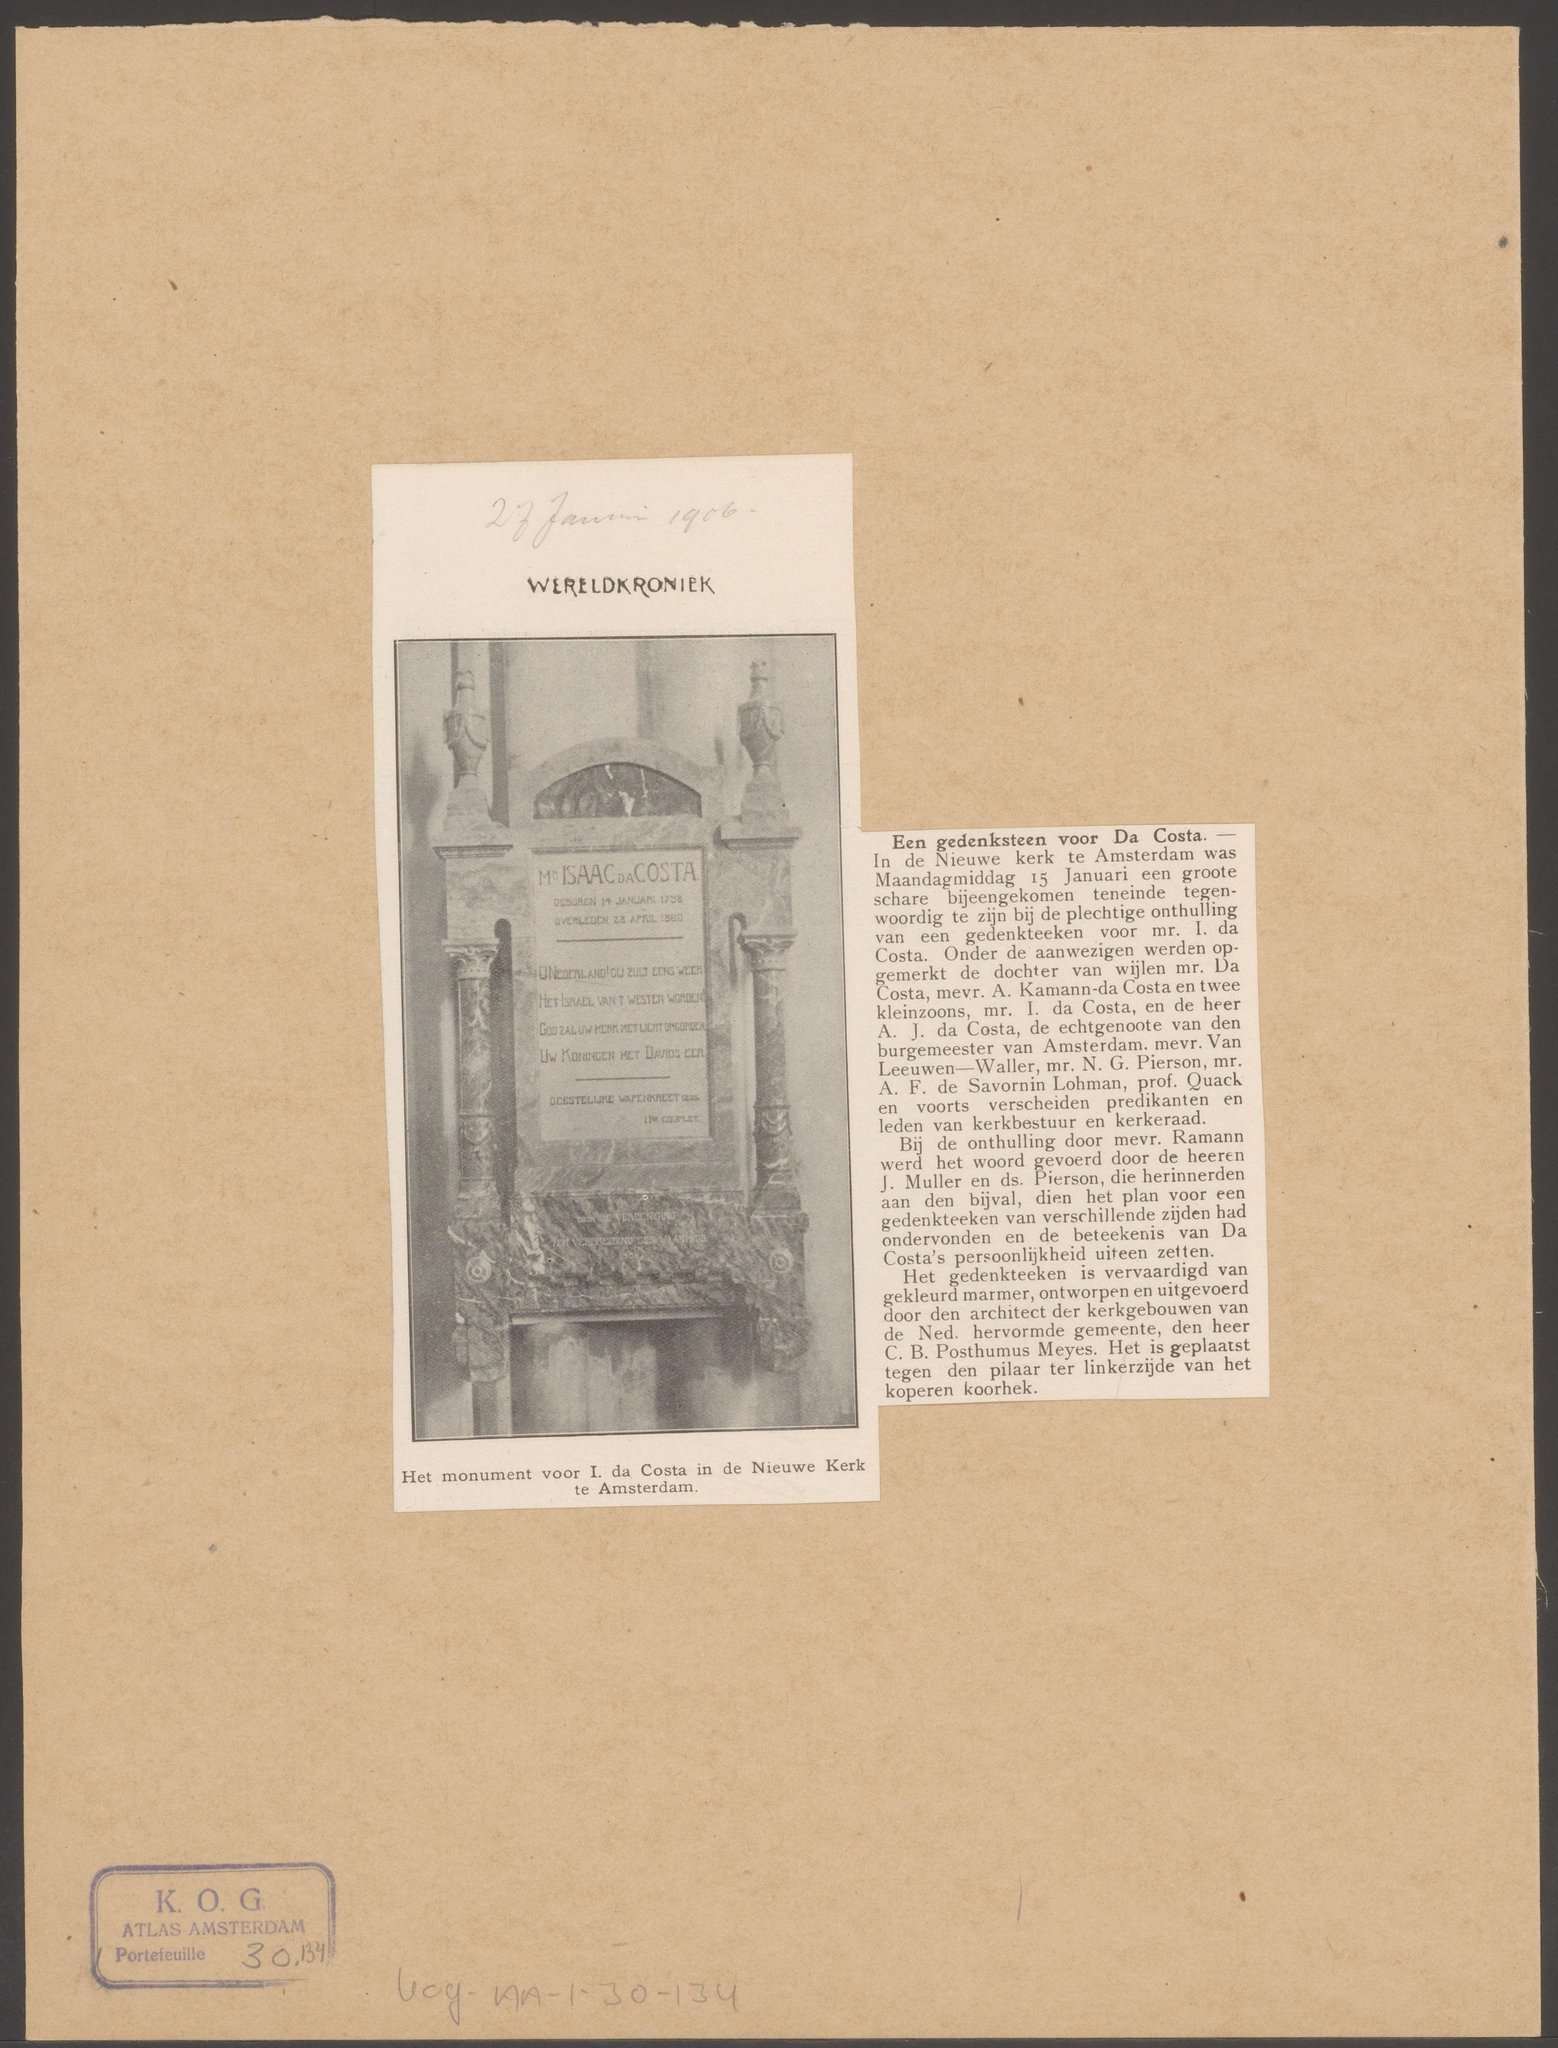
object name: photomechanical print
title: Het monument voor I. da Costa in de Nieuwe Kerk te Amsterdam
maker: Anonymous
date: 1906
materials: paper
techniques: letterpress printing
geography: netherlands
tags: epitaph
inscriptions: collector's mark: Lugt 1641b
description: Onderwerpsrubriek binnen de Atlas Amsterdam: Kerkwezen: Hervormde Gemeente: Nieuwe Kerk van binnen.